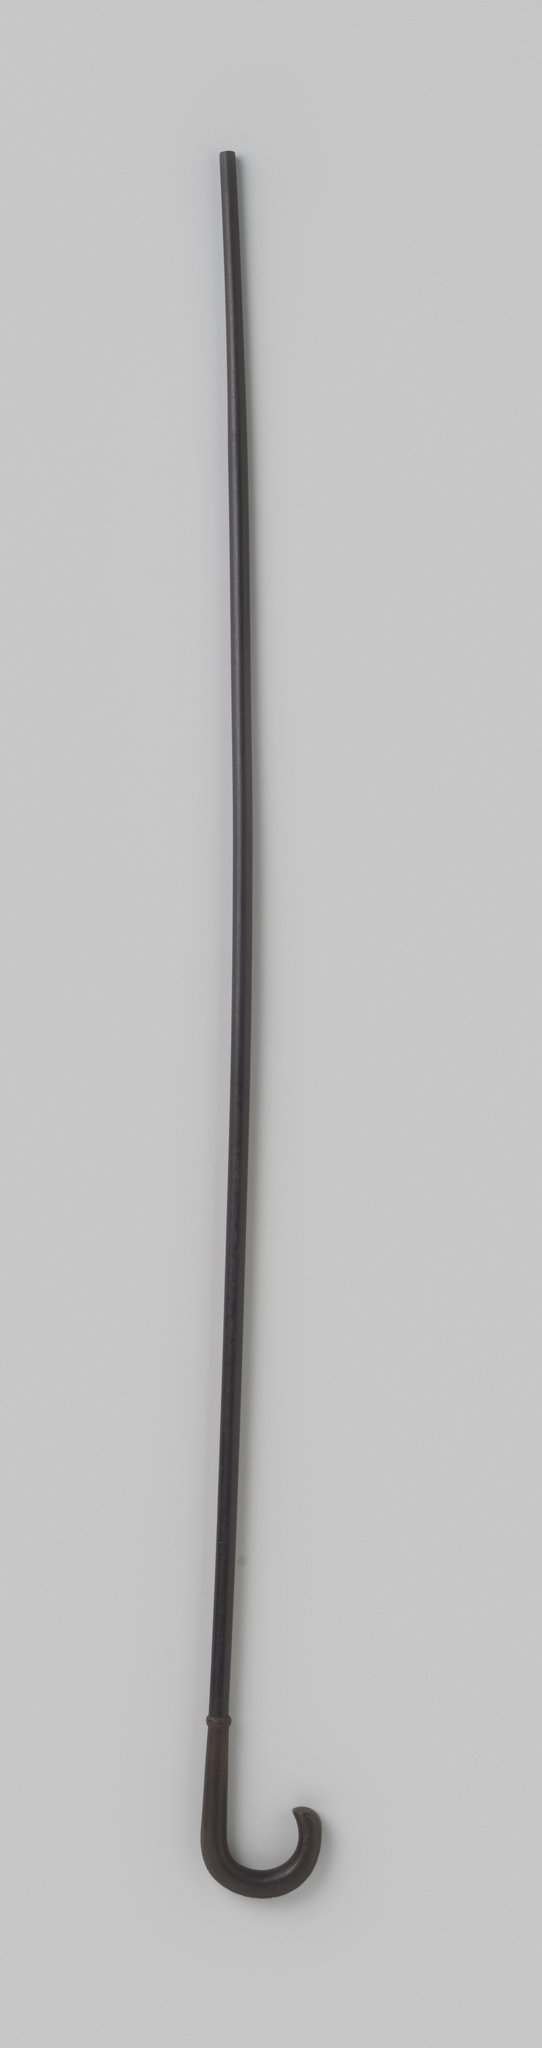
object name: onderstok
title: Onderstok van een paraplu of parasol van zwart geverfd hout met een ronde haak, waarin een bladmotief is gekerfd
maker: gustav schnitzler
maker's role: paraplufabrikant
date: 1920-1940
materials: wood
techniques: cutting, painting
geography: nijmegen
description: Onderstok van een parapluie of parasol van zwart geverfd hout met een ronde haak, waarin een bladmotief is gekerfd.